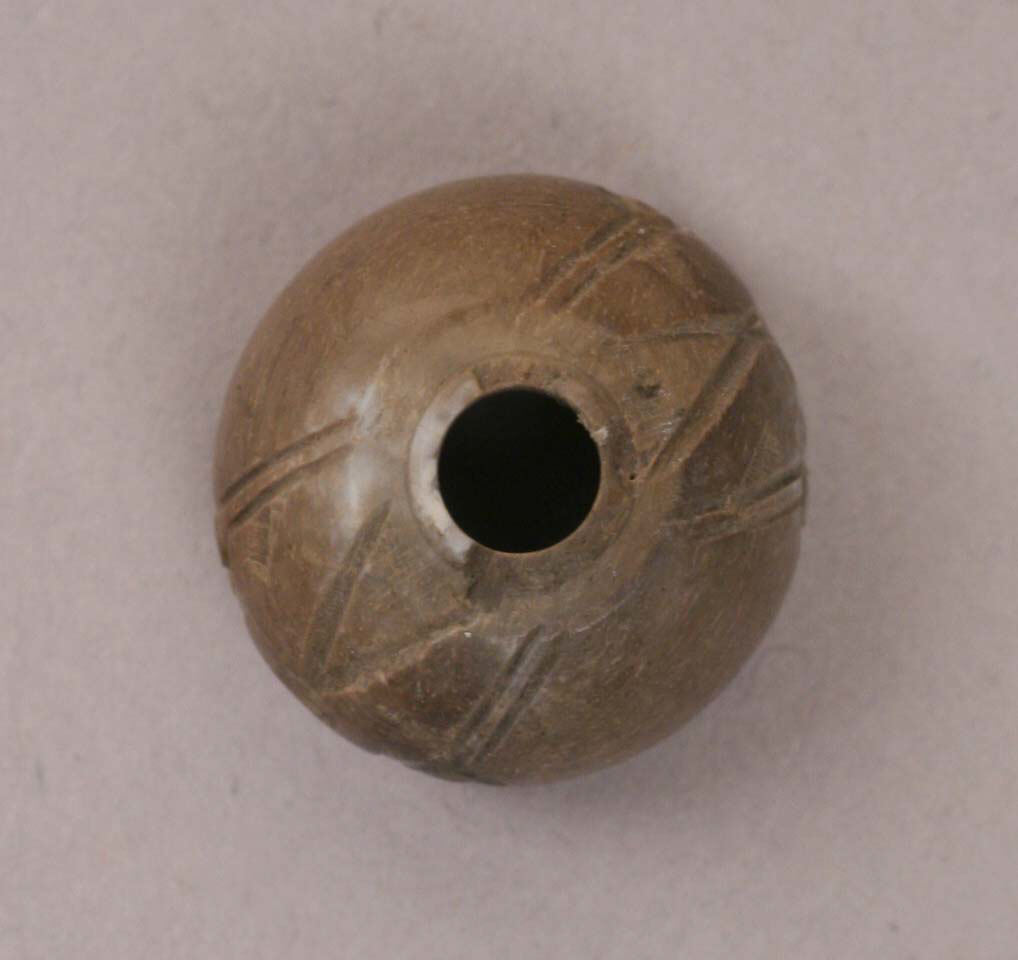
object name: button or bead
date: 801-1000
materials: bone, paint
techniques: incising, inlay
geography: iran